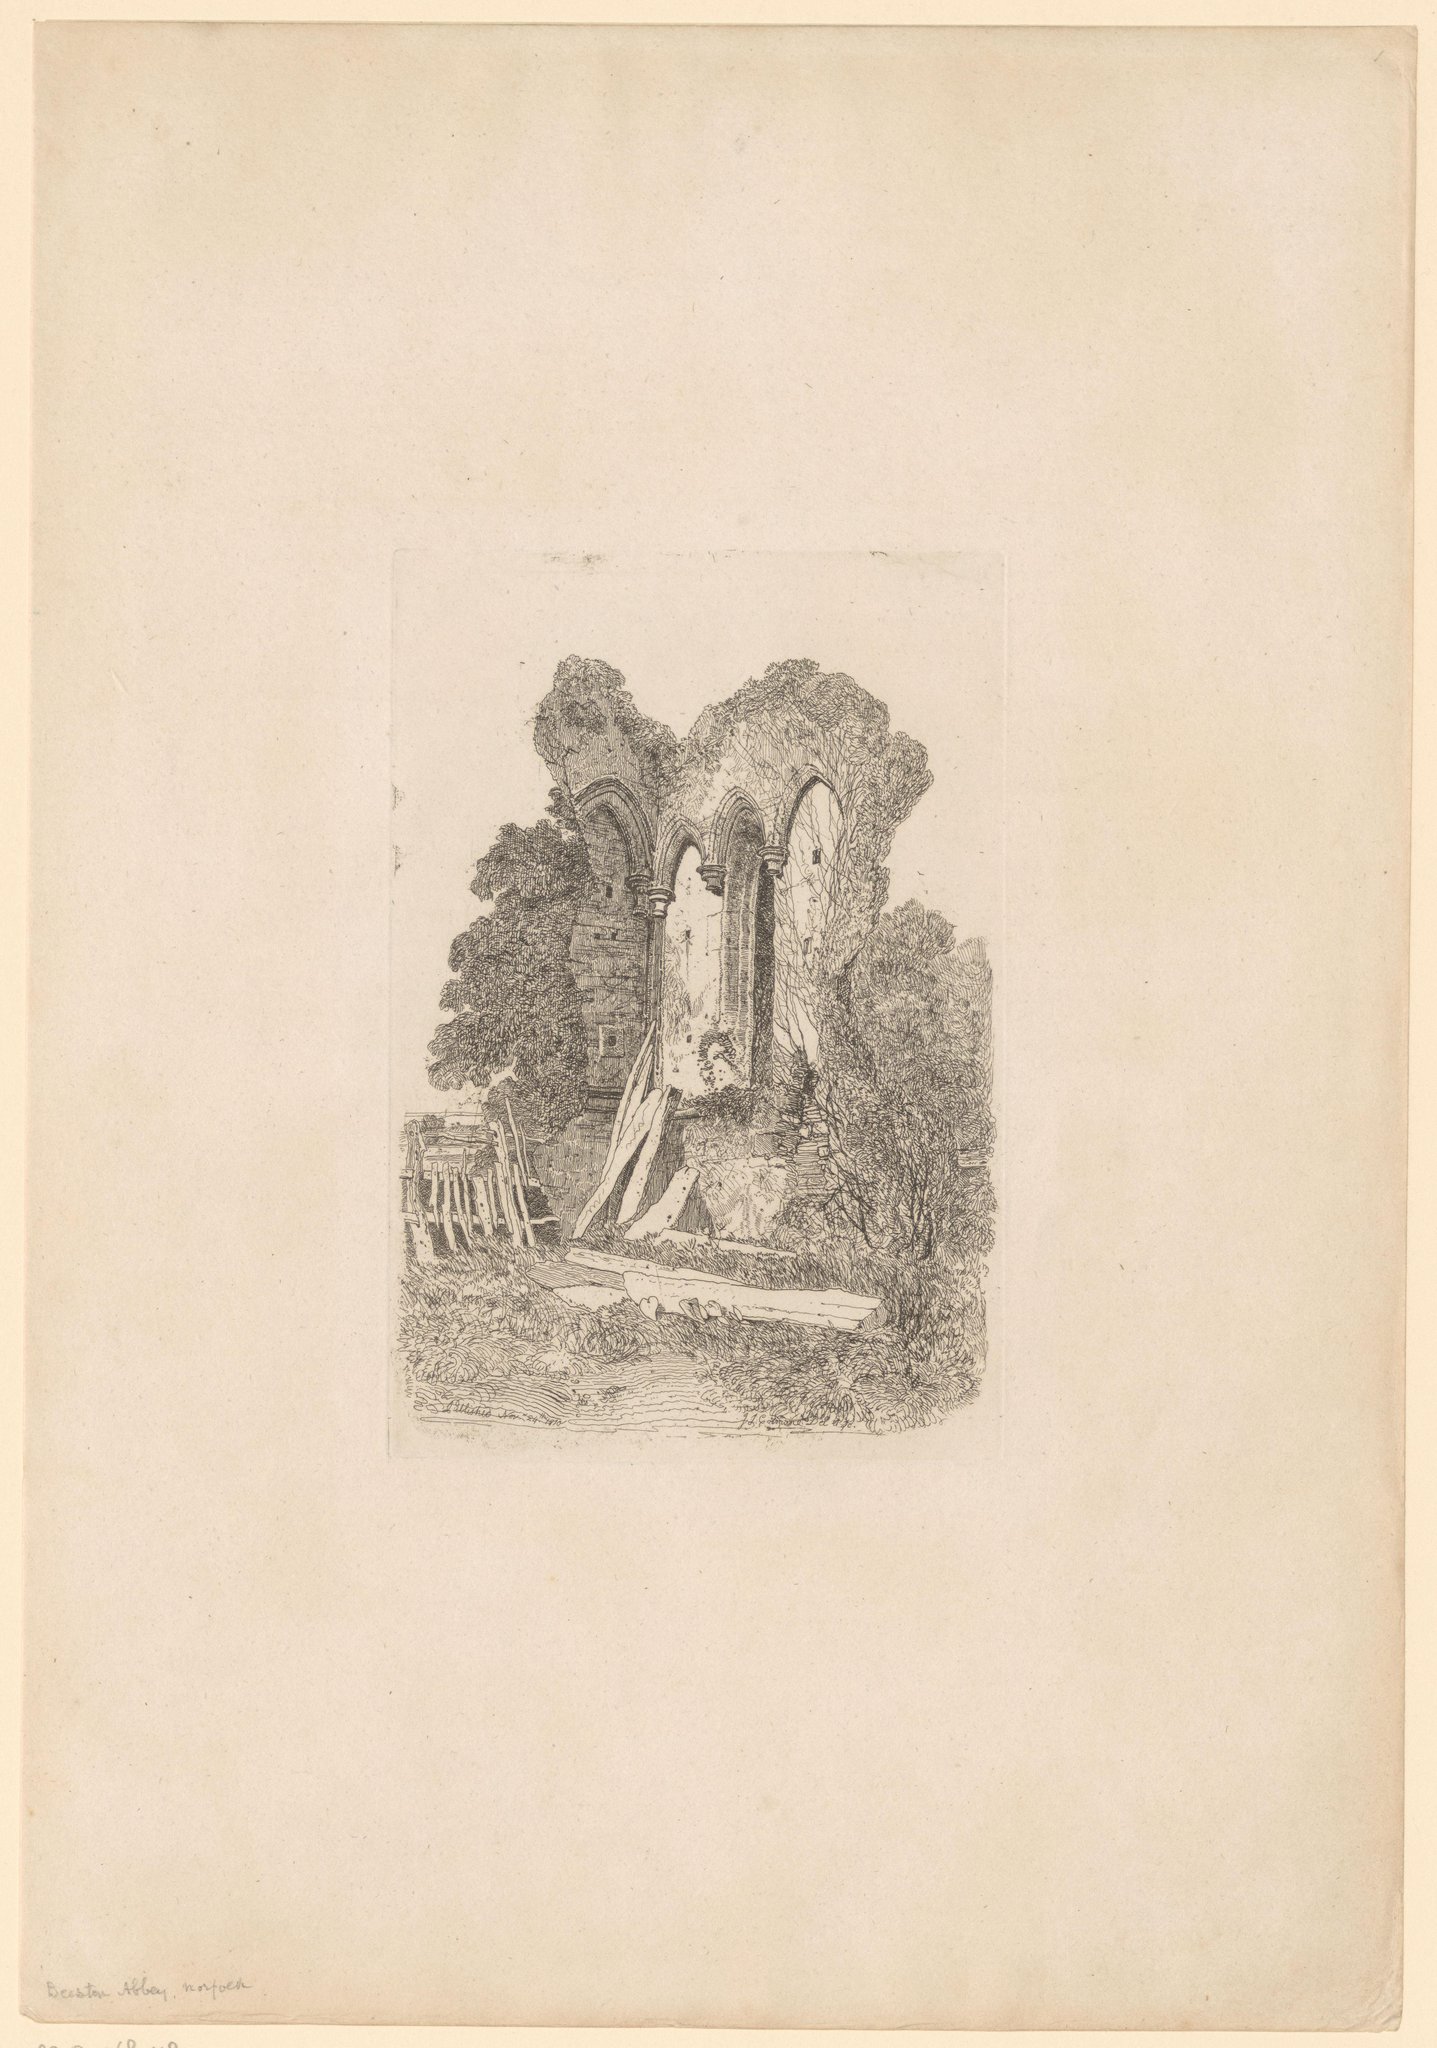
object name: print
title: Etchings by John Sell Cotman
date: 1810-1811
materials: paper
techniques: etching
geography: london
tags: ruin of church, monastery, etc.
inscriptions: collector's mark: Lugt 2760, collector's mark: Lugt 2228